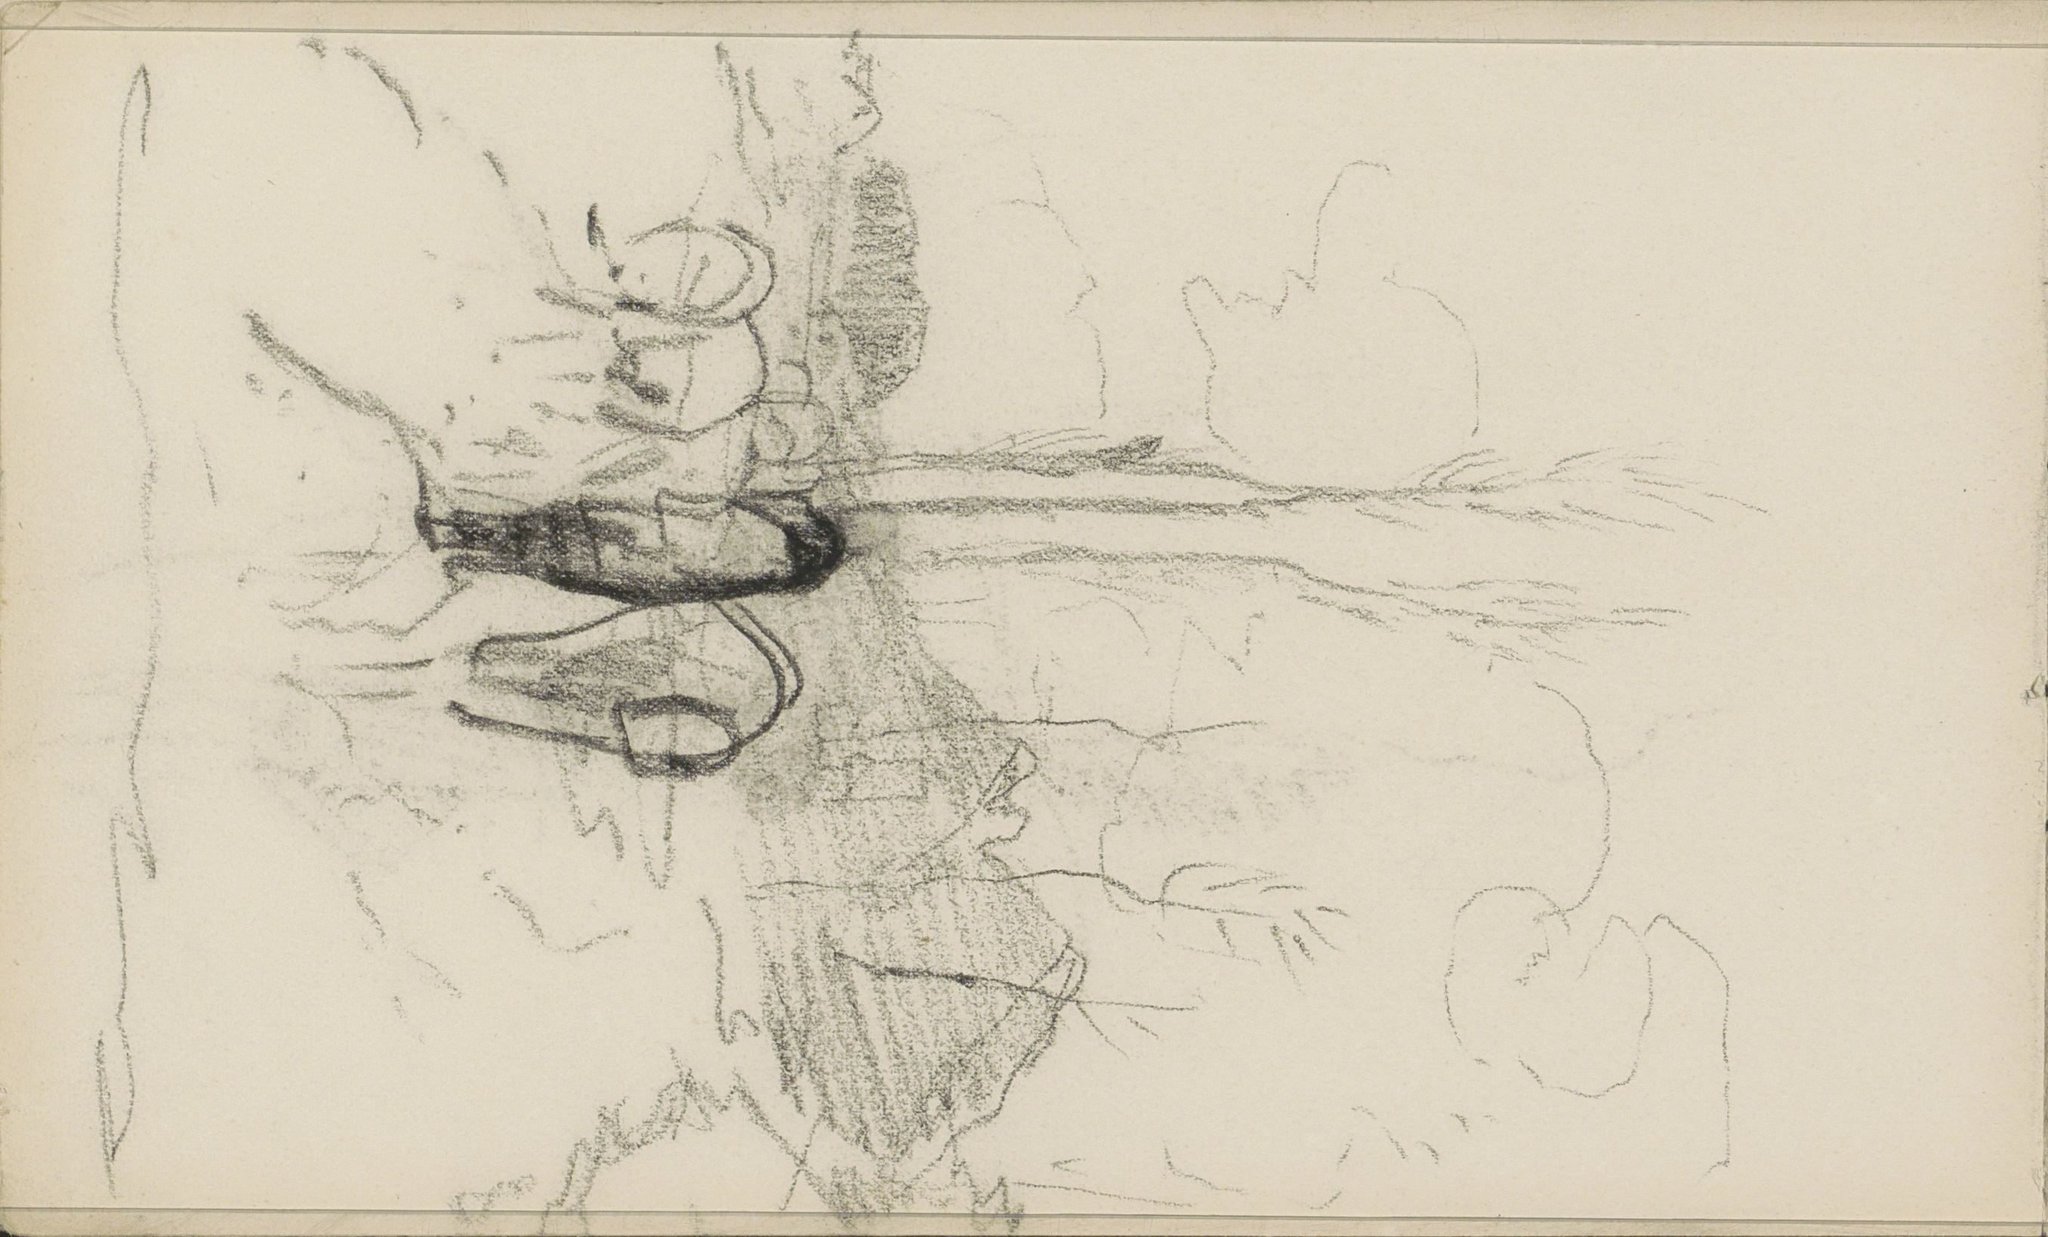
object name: sketchbook leaf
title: Figuur en enkele dieren, mogelijk koeien, op een landweg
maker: anton mauve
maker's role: draughtsman, painter, print maker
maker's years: 1838-1888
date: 1848-1888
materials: chalk, paper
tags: rural housing, e.g. country-house, villa, cottage, landscapes (+ landscape with figures, staffage)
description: Op de achtergrond twee huizen. Blad 22 verso uit een schetsboek met 33 bladen.